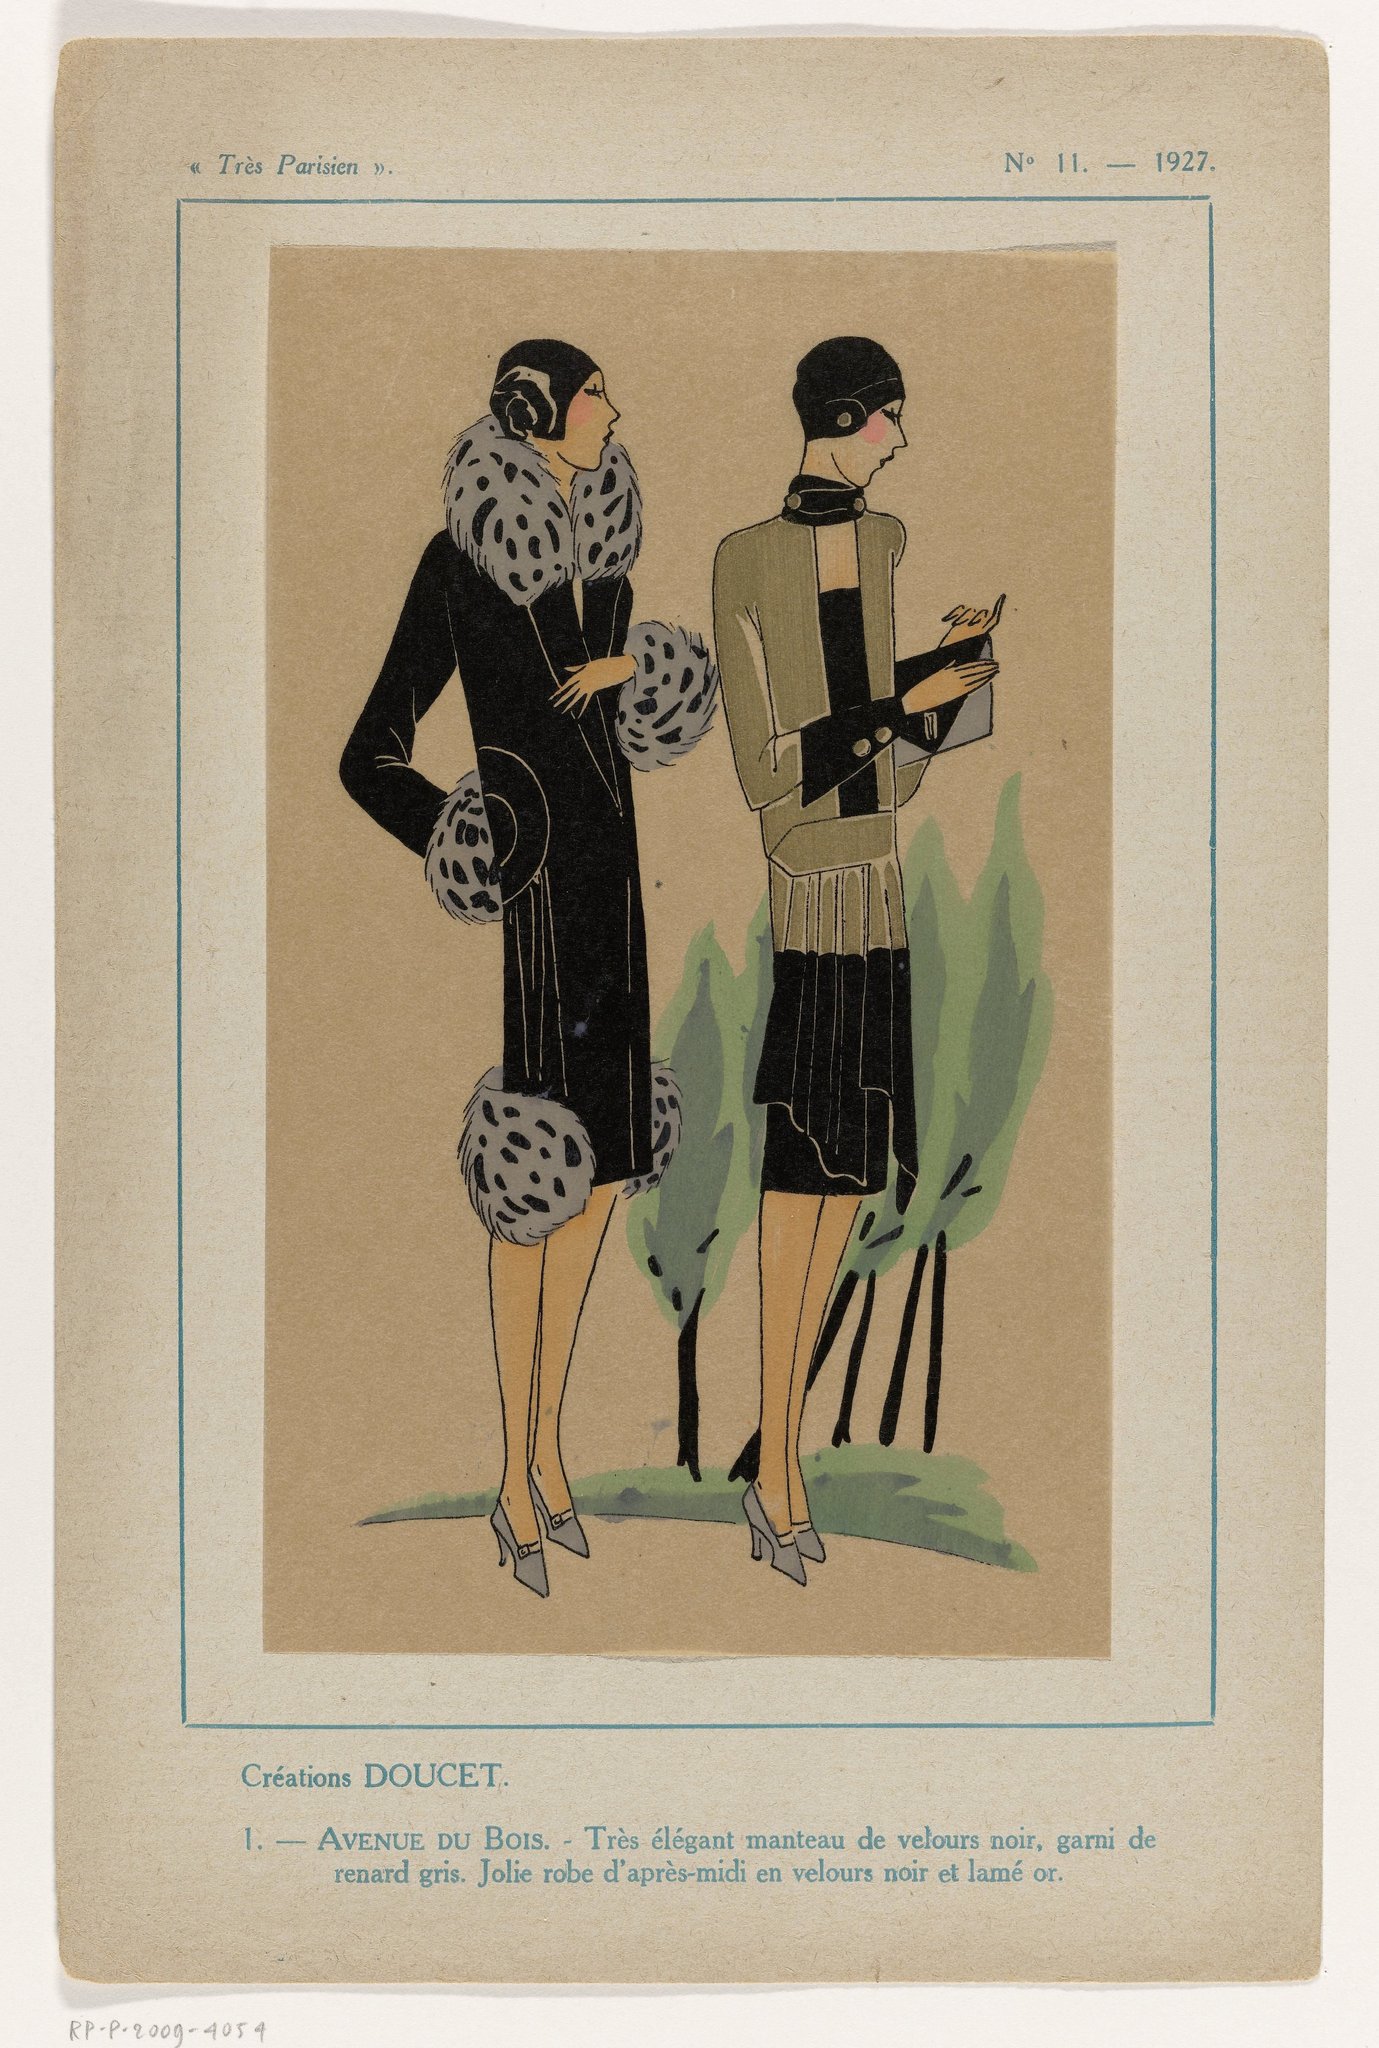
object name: fashion print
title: Très Parisien, 1927, No. 11 : -1: Créations Doucet (...)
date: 1927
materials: paper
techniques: hand coloring, letterpress printing, lithography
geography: paris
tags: bag (handbag) (+ women's clothes), dress, gown: day dress (+ women's clothes), coat (+ women's clothes), head-gear: cap (+ women's clothes), fashion plates, neck-gear: collar (+ fur used for clothes)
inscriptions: caption: ‘Créations DOUCET. / 1. - AVENUE DU BOIS. - Très élégant manteau de velours noir, garni de renard gris. Jolie robe d'après-midi en velours noir et lamé or.’, title: ‘"Très Parisien" / No 11. - 1927’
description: Ontwerpen van Doucet. Mantel van zwart fluweel, gegarneerd met grijs vossenbont. Middagjurk van zwart fluweel en goudlamé. Accessoires: cloche (pothoed) of muts, enveloptas, pumps. Prent uit het modetijdschrift Très Parisien (1920-1936).